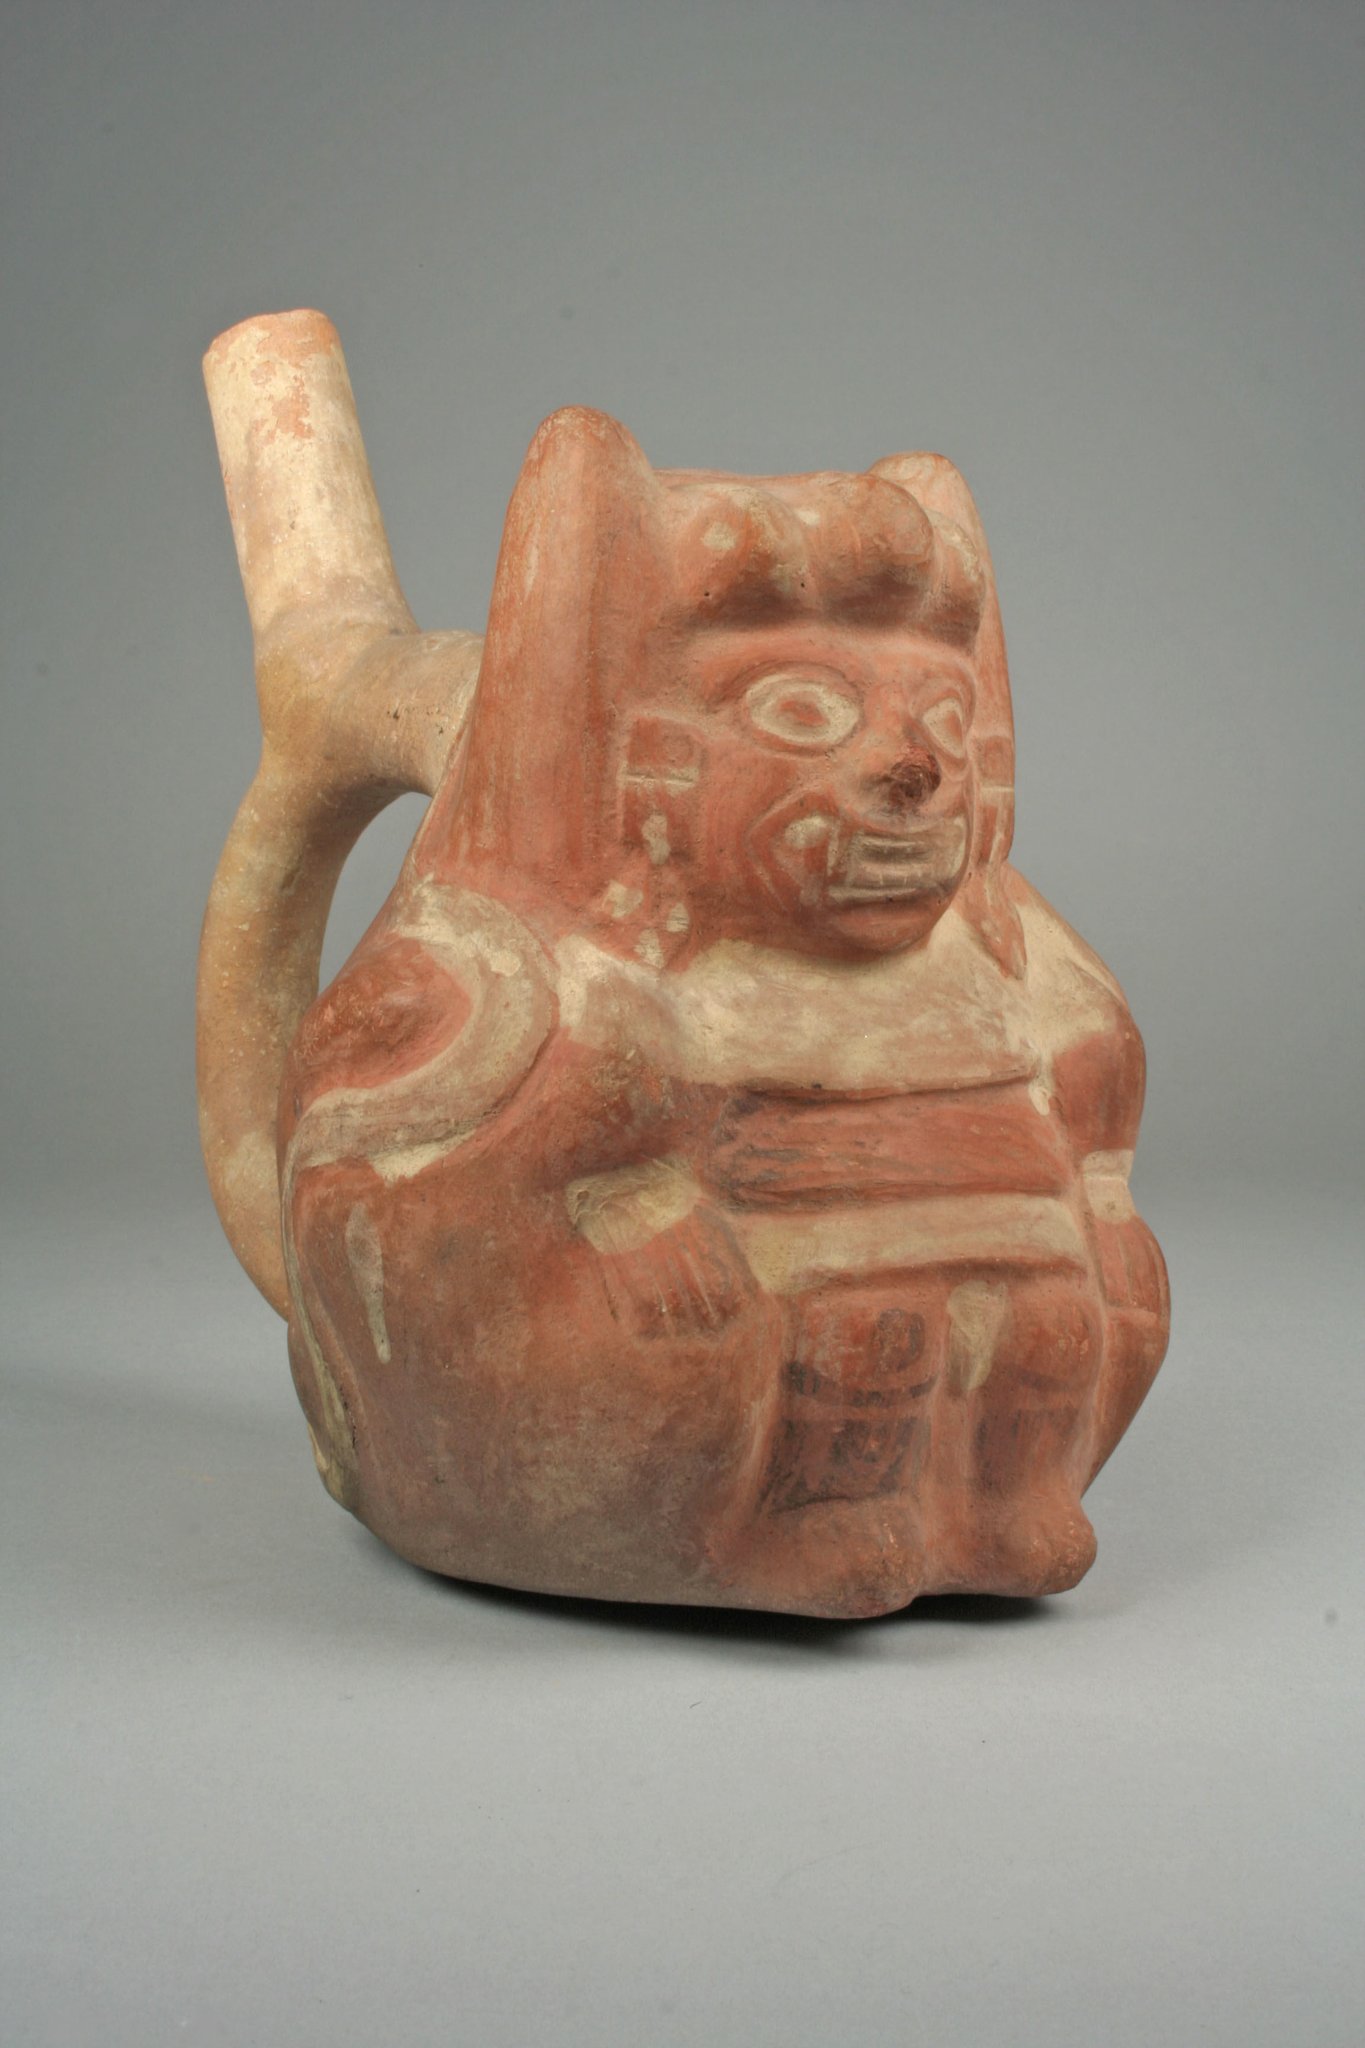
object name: bottle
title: Stirrup Spout Bottle with Figure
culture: moche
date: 301-700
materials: ceramic, pigment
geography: peru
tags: human figures